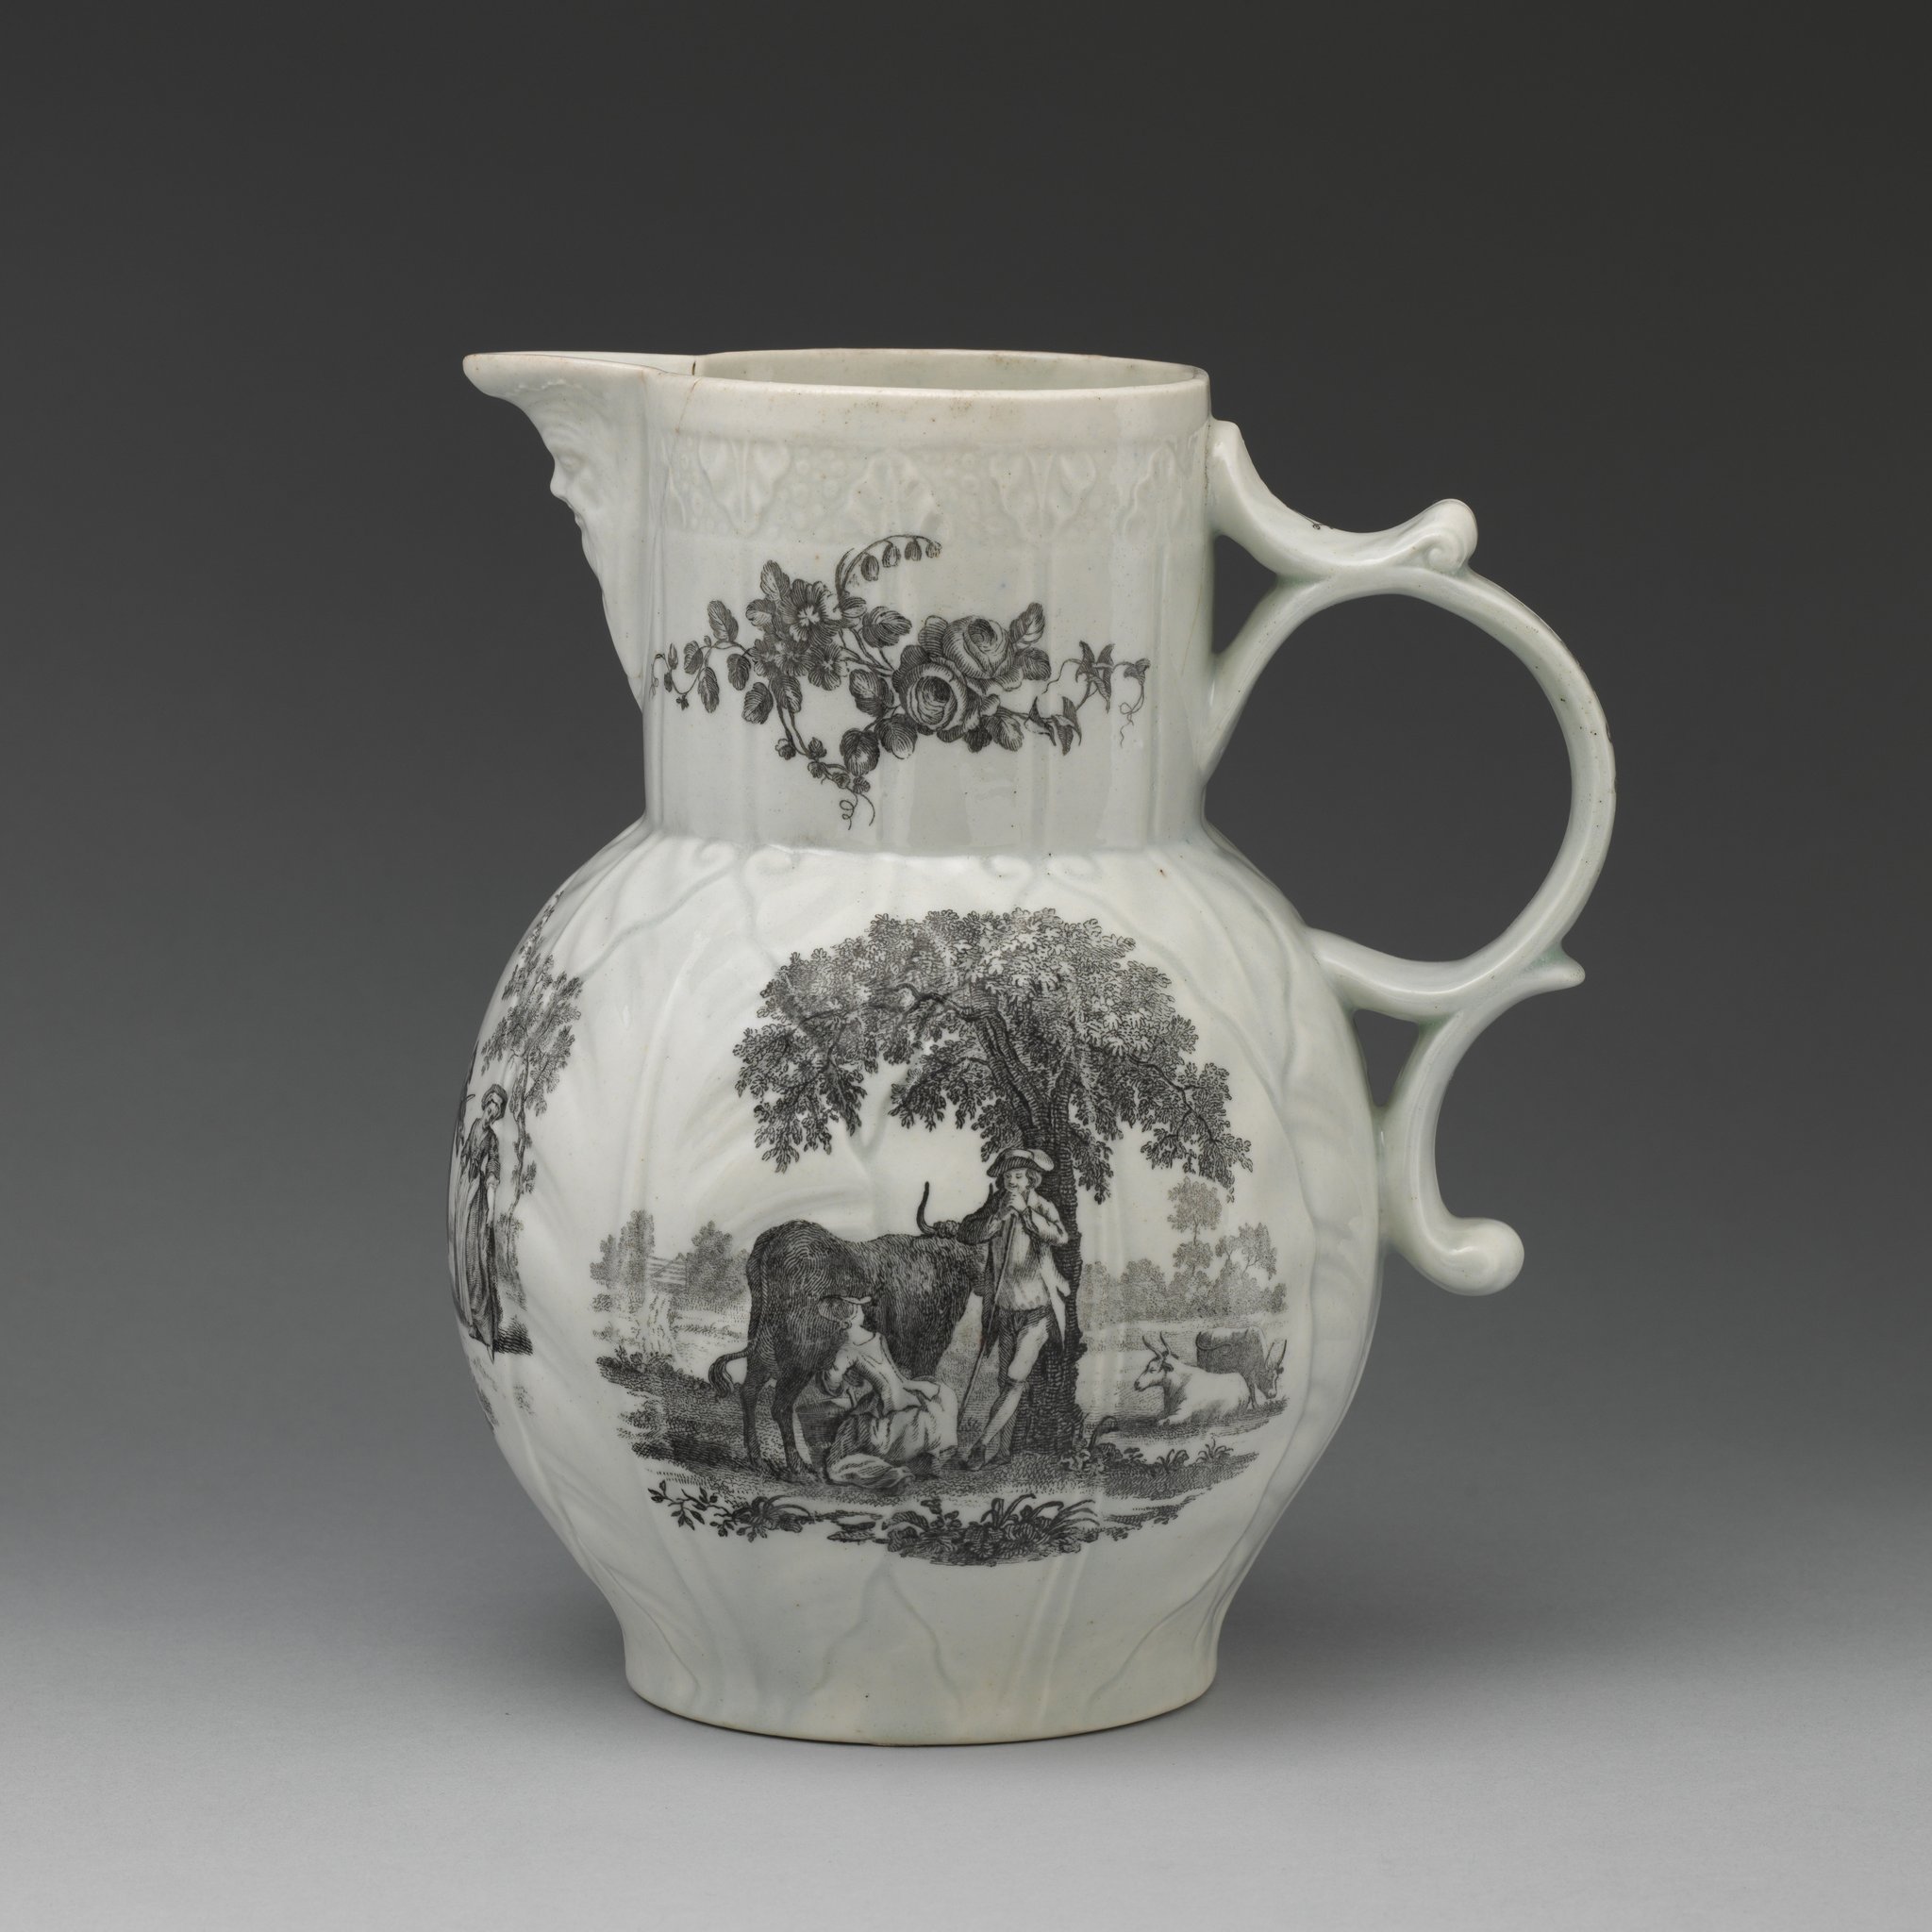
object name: jug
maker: worcester factory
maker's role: factory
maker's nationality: british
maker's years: 1751-2008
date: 1760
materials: soft paste porcelain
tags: animals,men,trees